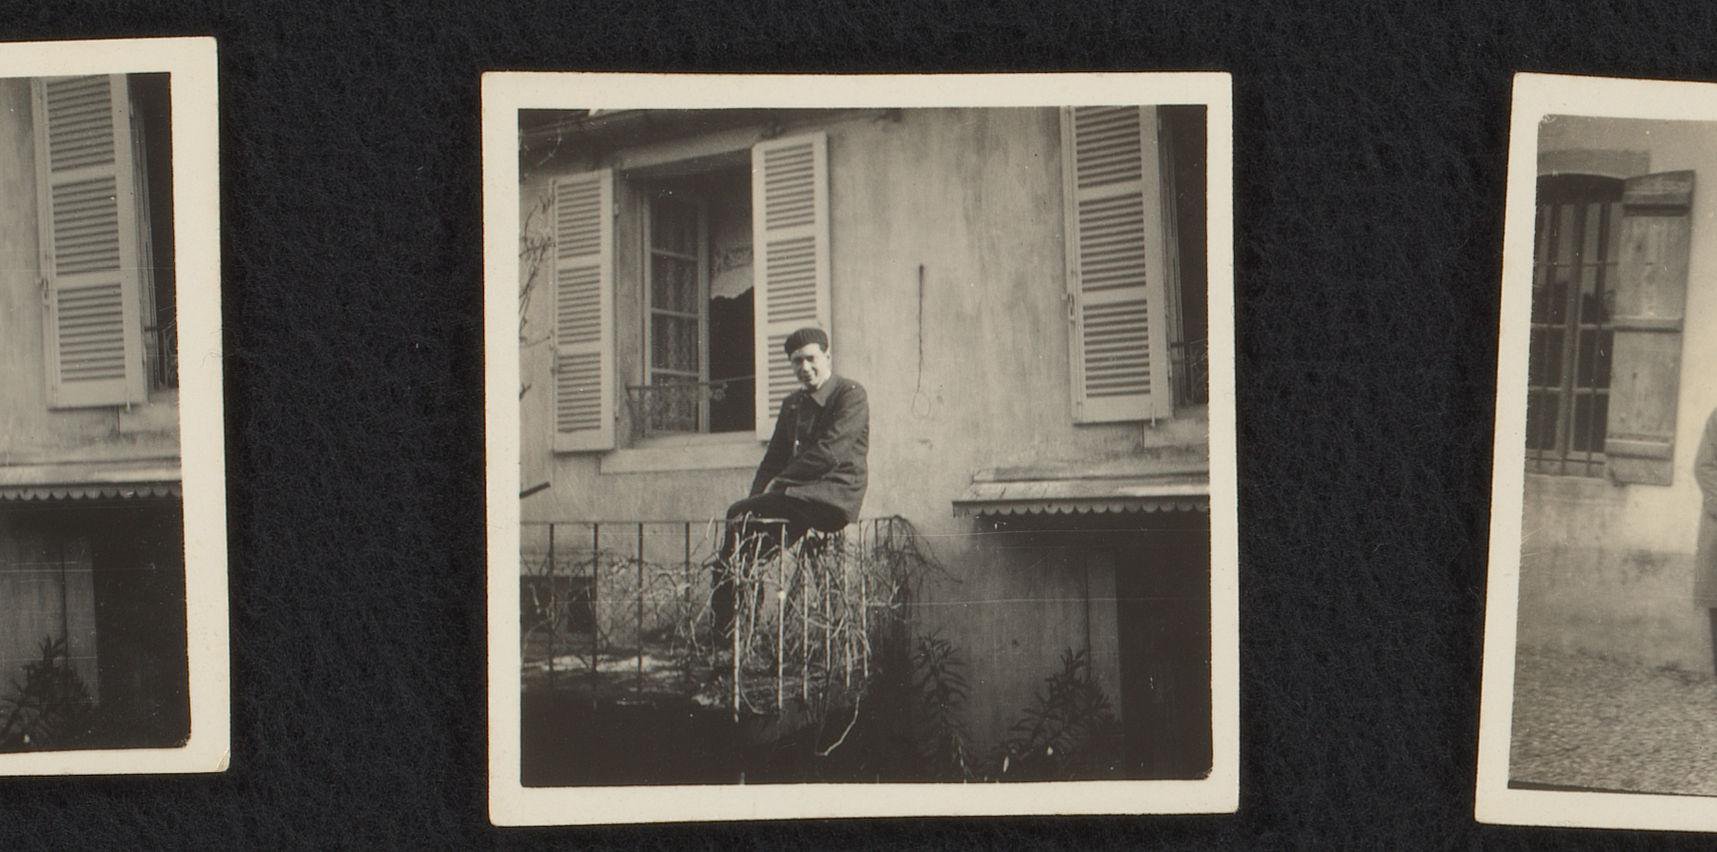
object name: photograph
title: Man op balkon voor huis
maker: Anonymous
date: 1930-1950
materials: photographic support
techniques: gelatin silver print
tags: historical persons not known by name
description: Man zittend op railing van balkon voor huis. In envelop met losse foto's behorend bij het fotoalbum over de bewoners van het huis aan de Reguliersgracht te Amsterdam in de periode 1924-1932.